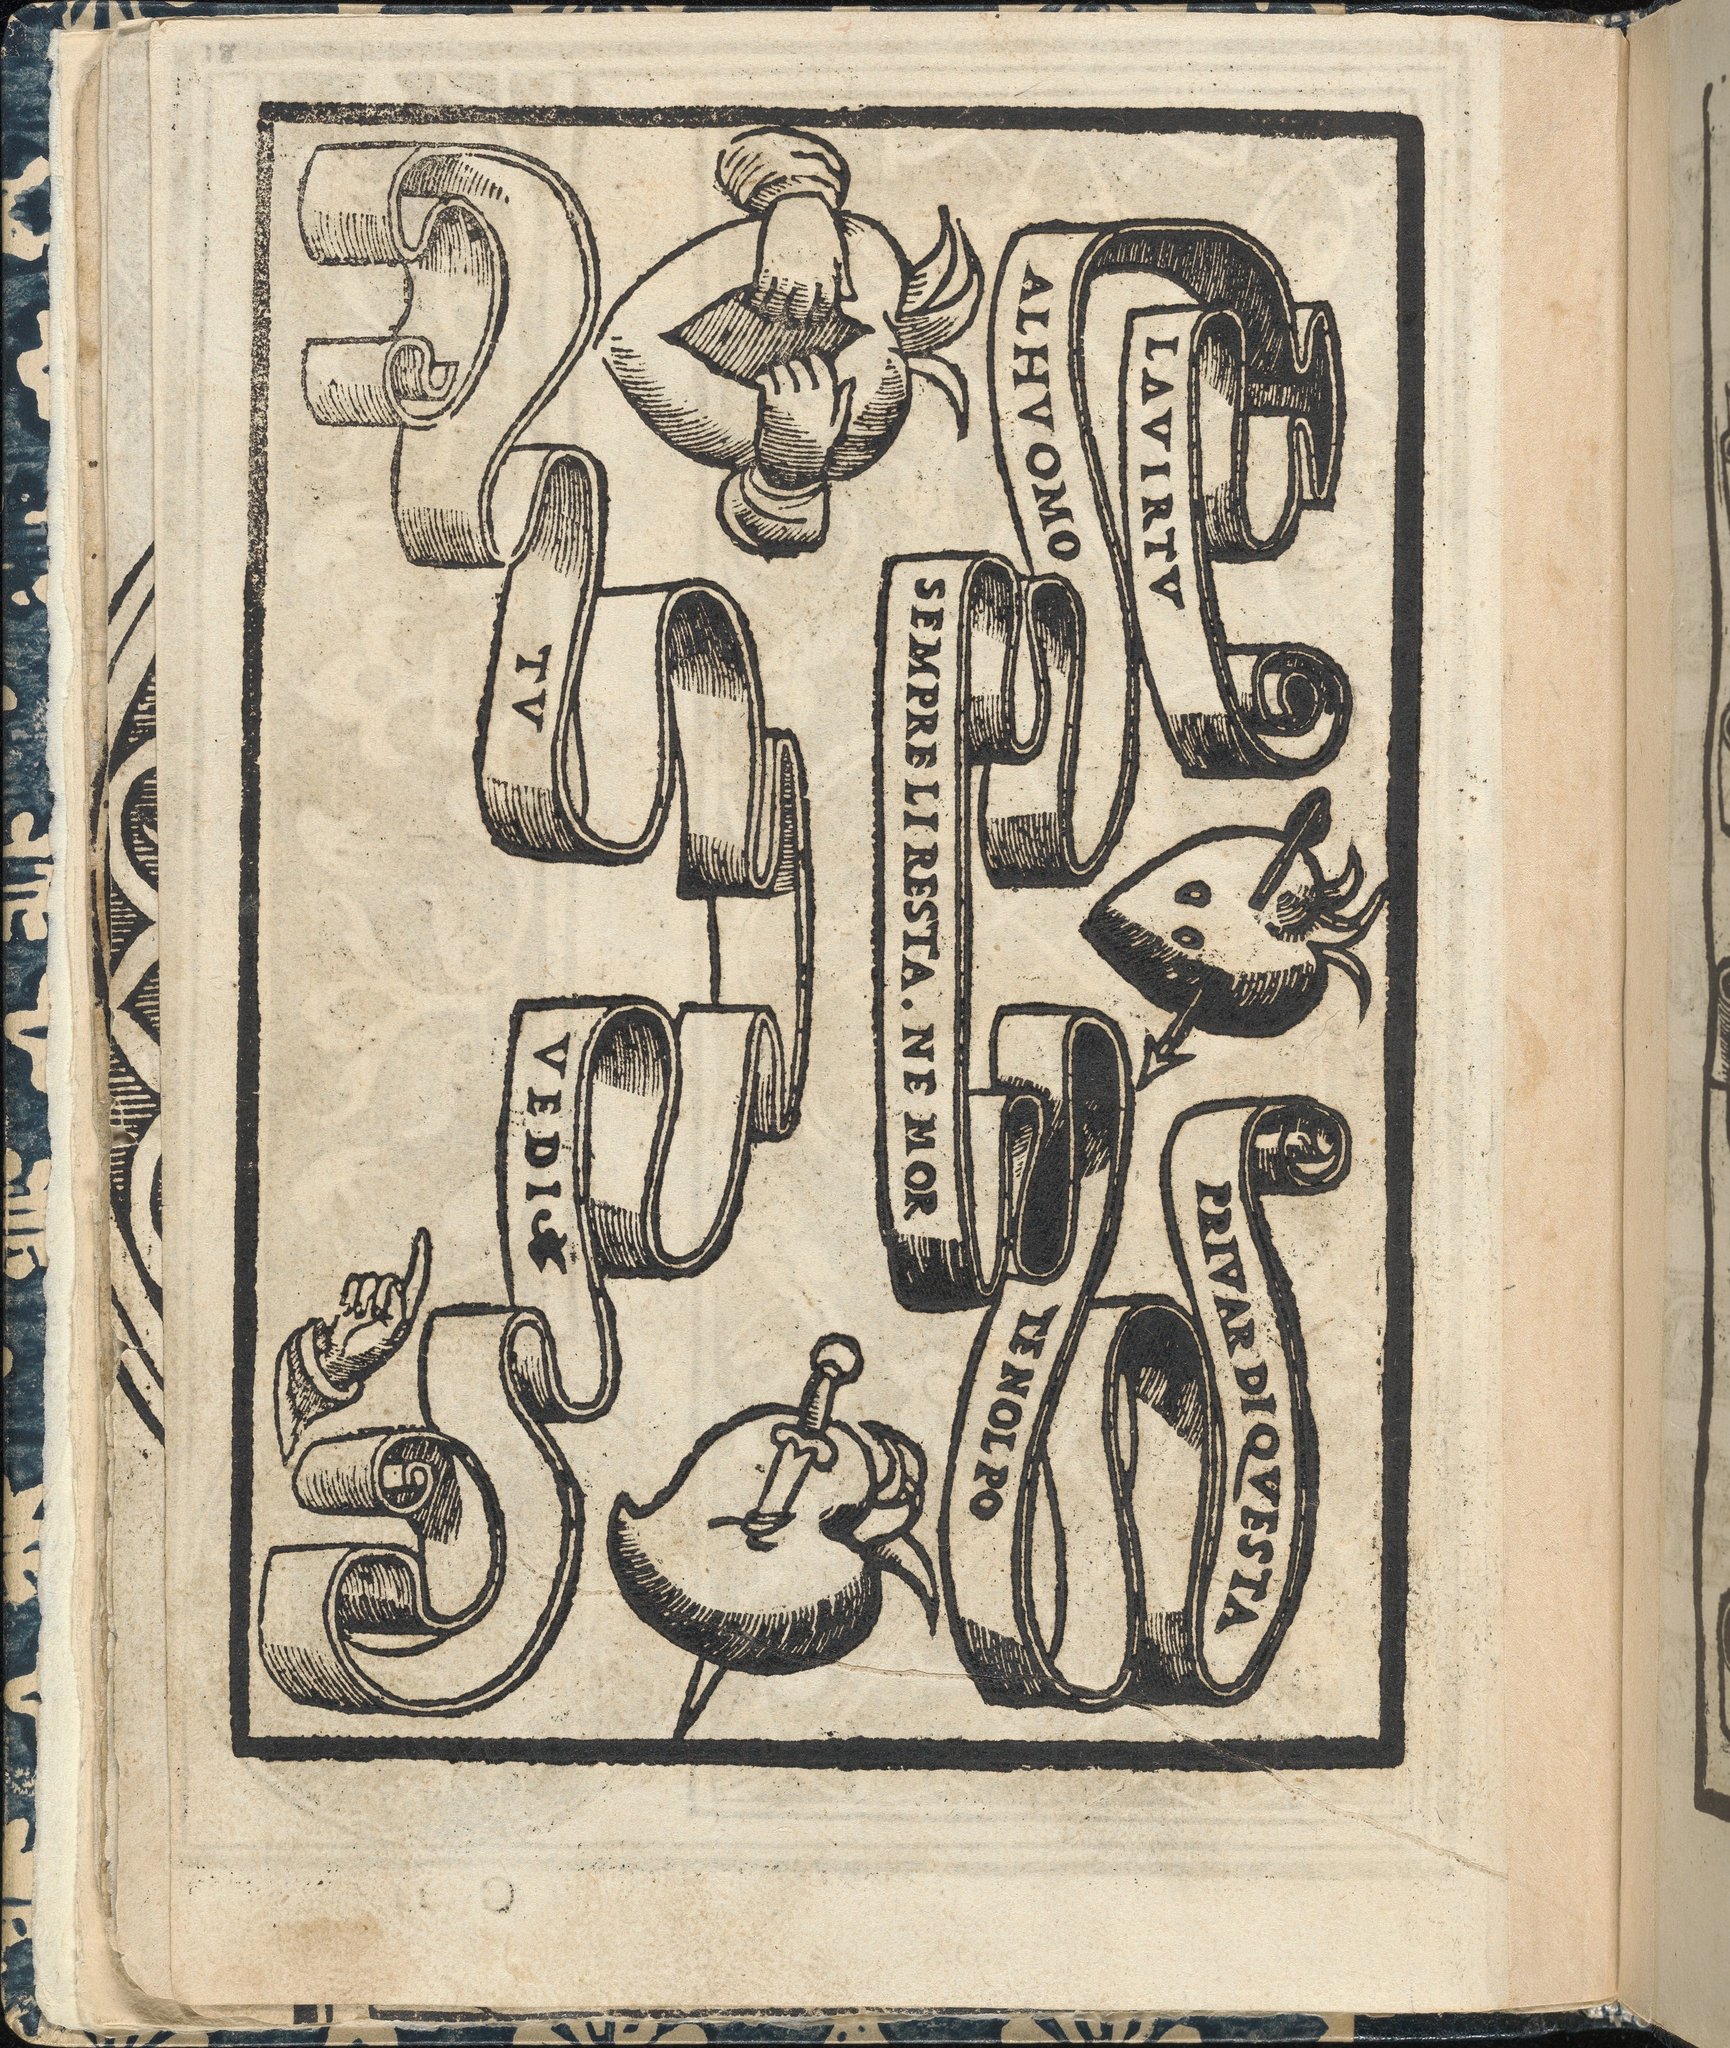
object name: book print ornament architecture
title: Essempio di recammi, page 18 (verso)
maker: giovanni antonio tagliente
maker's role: author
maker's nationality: italian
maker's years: 1465-1528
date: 1530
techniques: woodcut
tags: flags